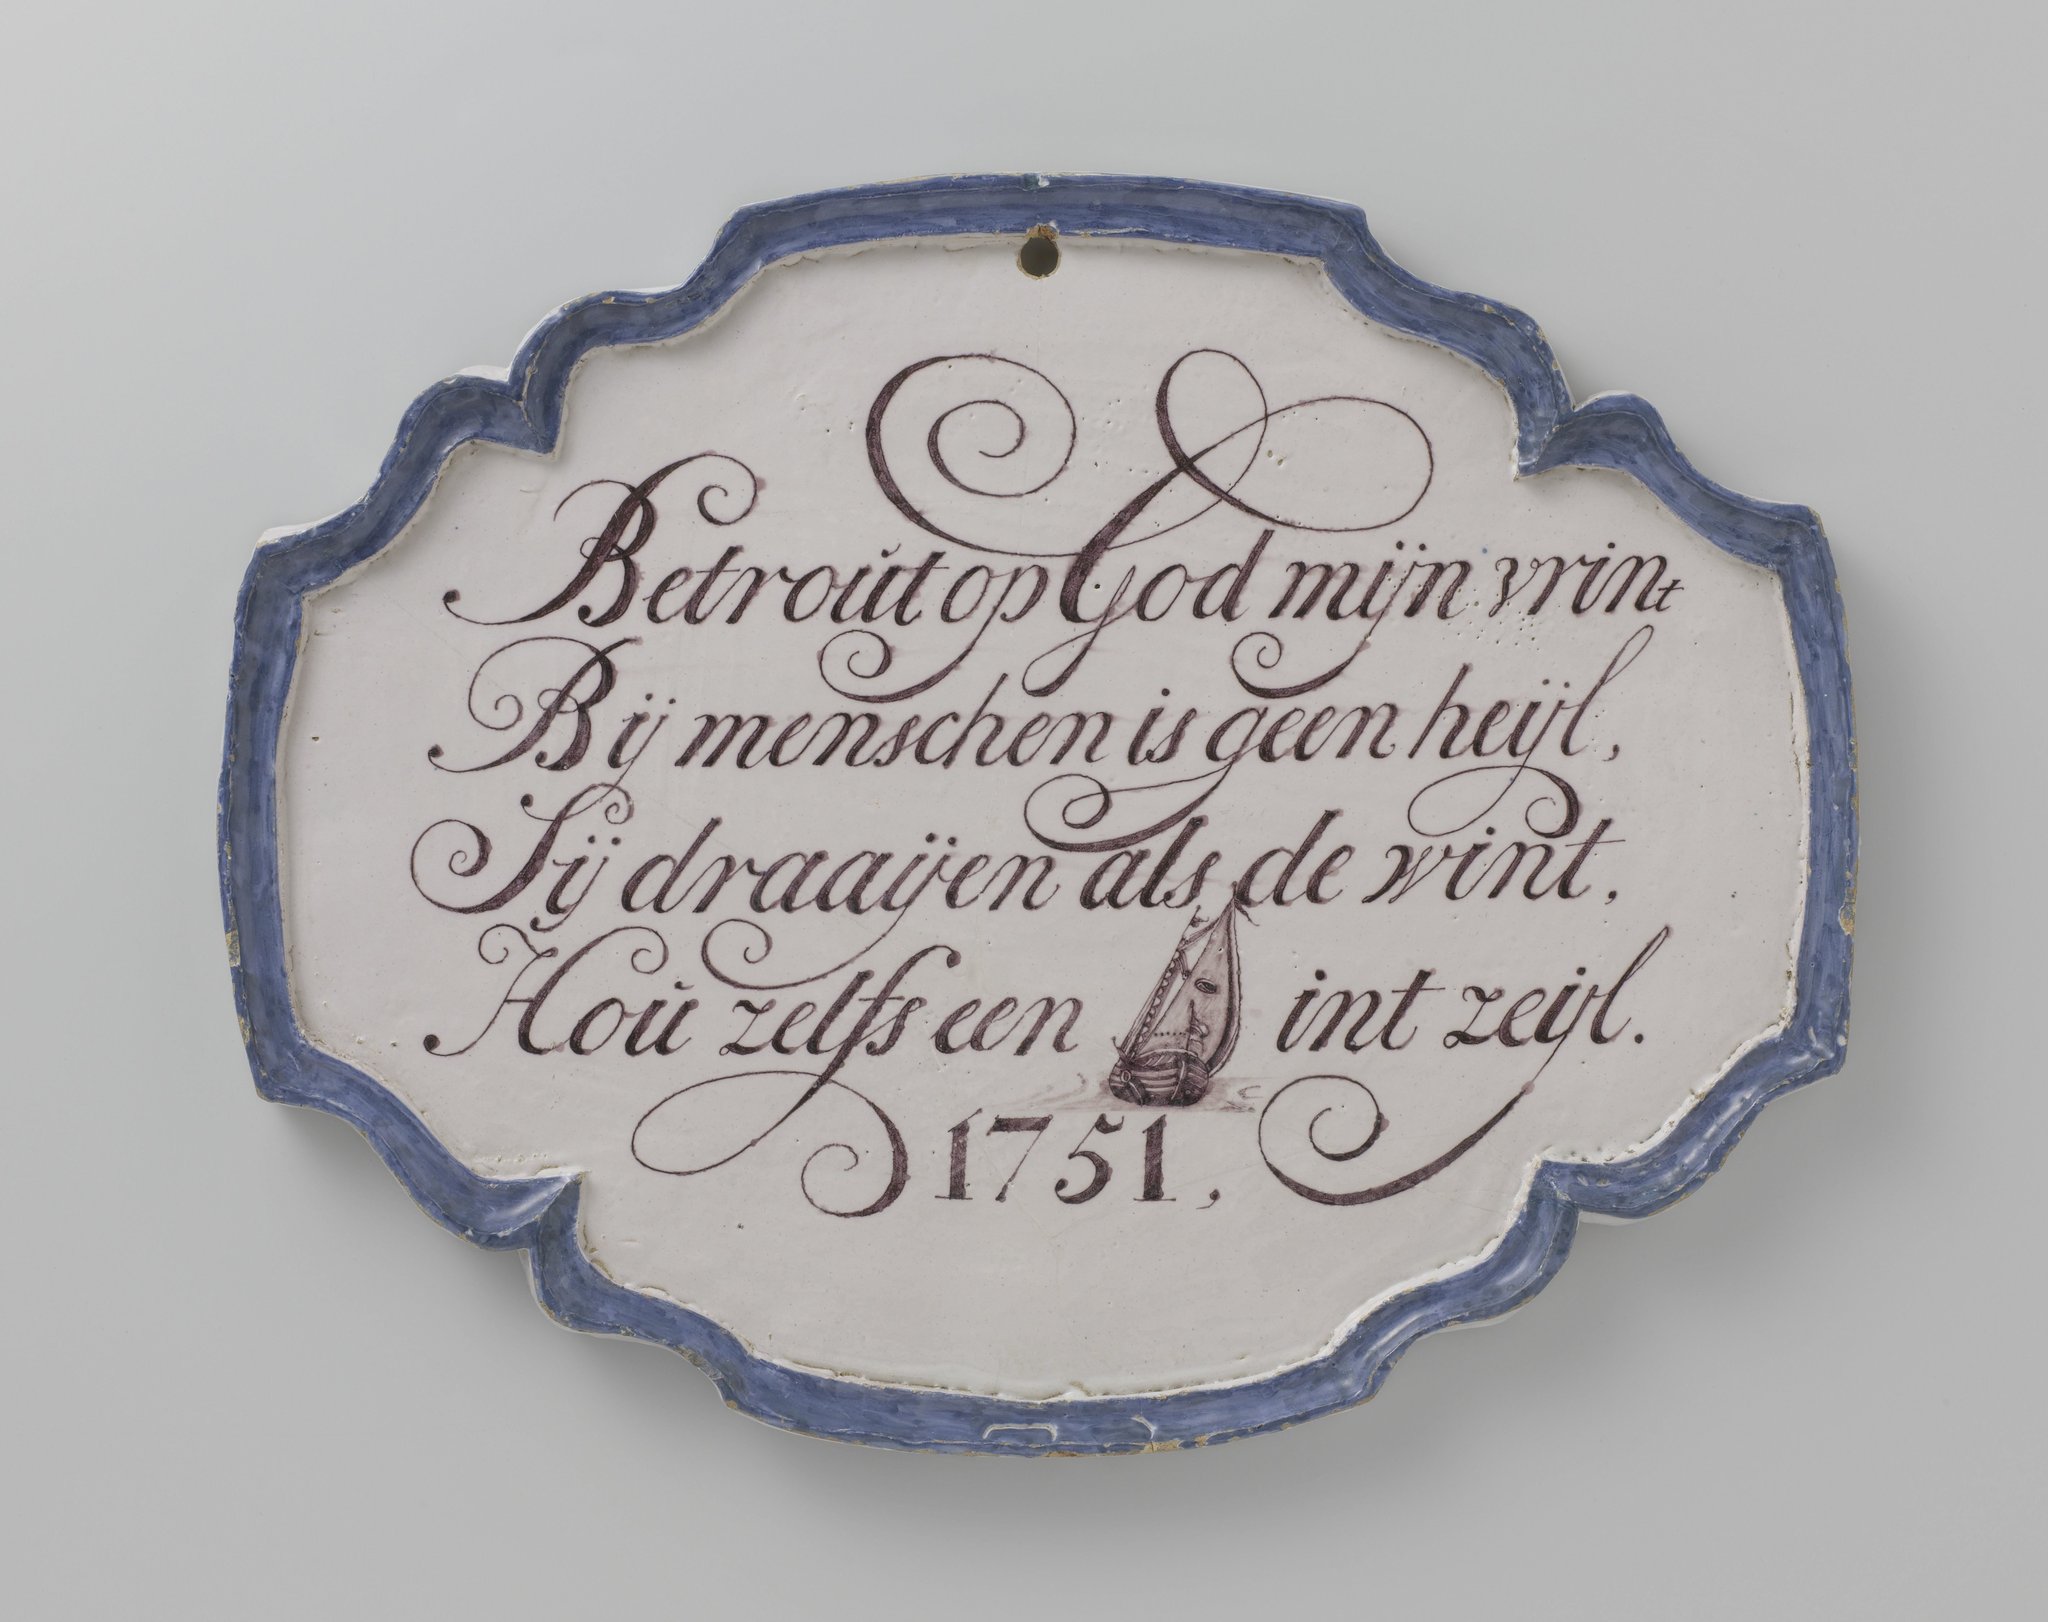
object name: plate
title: Plaque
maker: Anonymous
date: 1751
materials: faience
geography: amsterdam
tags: sailing-ship, sailing-boat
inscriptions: inscription: ‘Betrout op God mijn vrint/ Bij menschen is geen heijl/ Sy draaijen als de wint/ Hou zelfs een [rebus voor oog] in het zeijl’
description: Plaque van faience, beschilderd met de tekst: Betrout op God mijn vrint // Bij menschen is geen heijl // Sy draaijen als de wint // Hou zelfs een [rebus voor oog] in het zeijl.